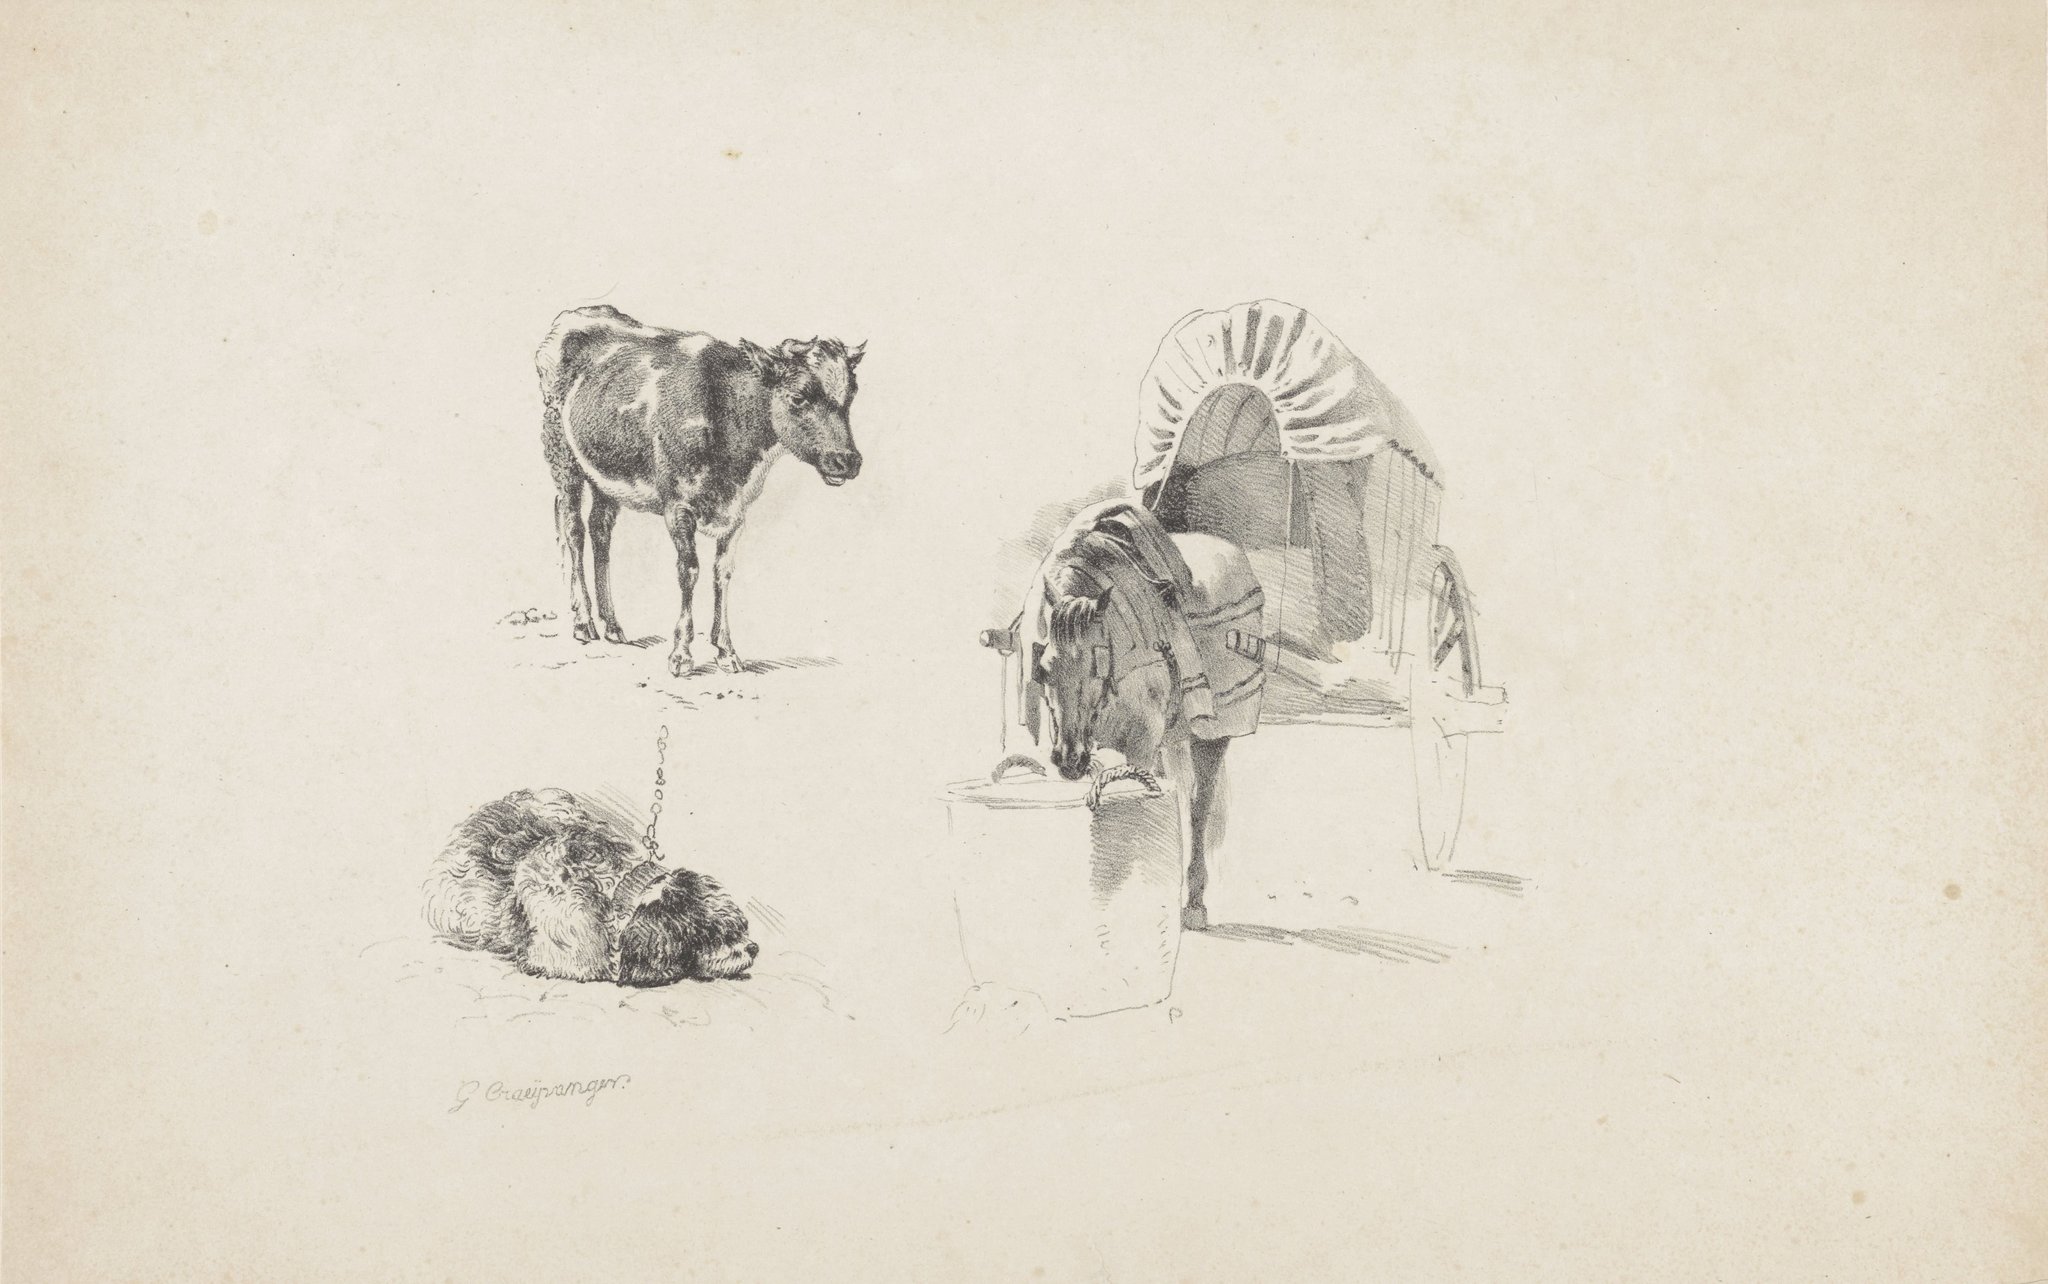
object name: print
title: Beesten Studien naar het Leven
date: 1827-1828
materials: paper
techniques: lithograph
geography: amsterdam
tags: calf, horse (+ conveyance for transport of loads and cargoes), dog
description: Waarschijnlijk is dit een prent voor: 'Beesten Studien naar het Leven op steen gebragt door G. Craeyvanger'. Amsterdam: Francois Buffa & Zoonen, 1828. Zie Swillens in Jaarboek Oud Utrecht. Volgens Swillens gedrukt door Ambroise Jobard. In Lijst van kunstwerken door beoefenaars en verzamelaars bijeengebragt, om verloot te worden ten behoeve van het vaderland; tentoongesteld te Amsterdam, in het nationale geregtshof, Amsterdam (C.A. Spin) 1831, p. 31, nr. 700 vermeld als uitgave van Daiwaille en Veldhuijzen. Daiwaille had eerder samengewerkt met Ambroise Jobard.